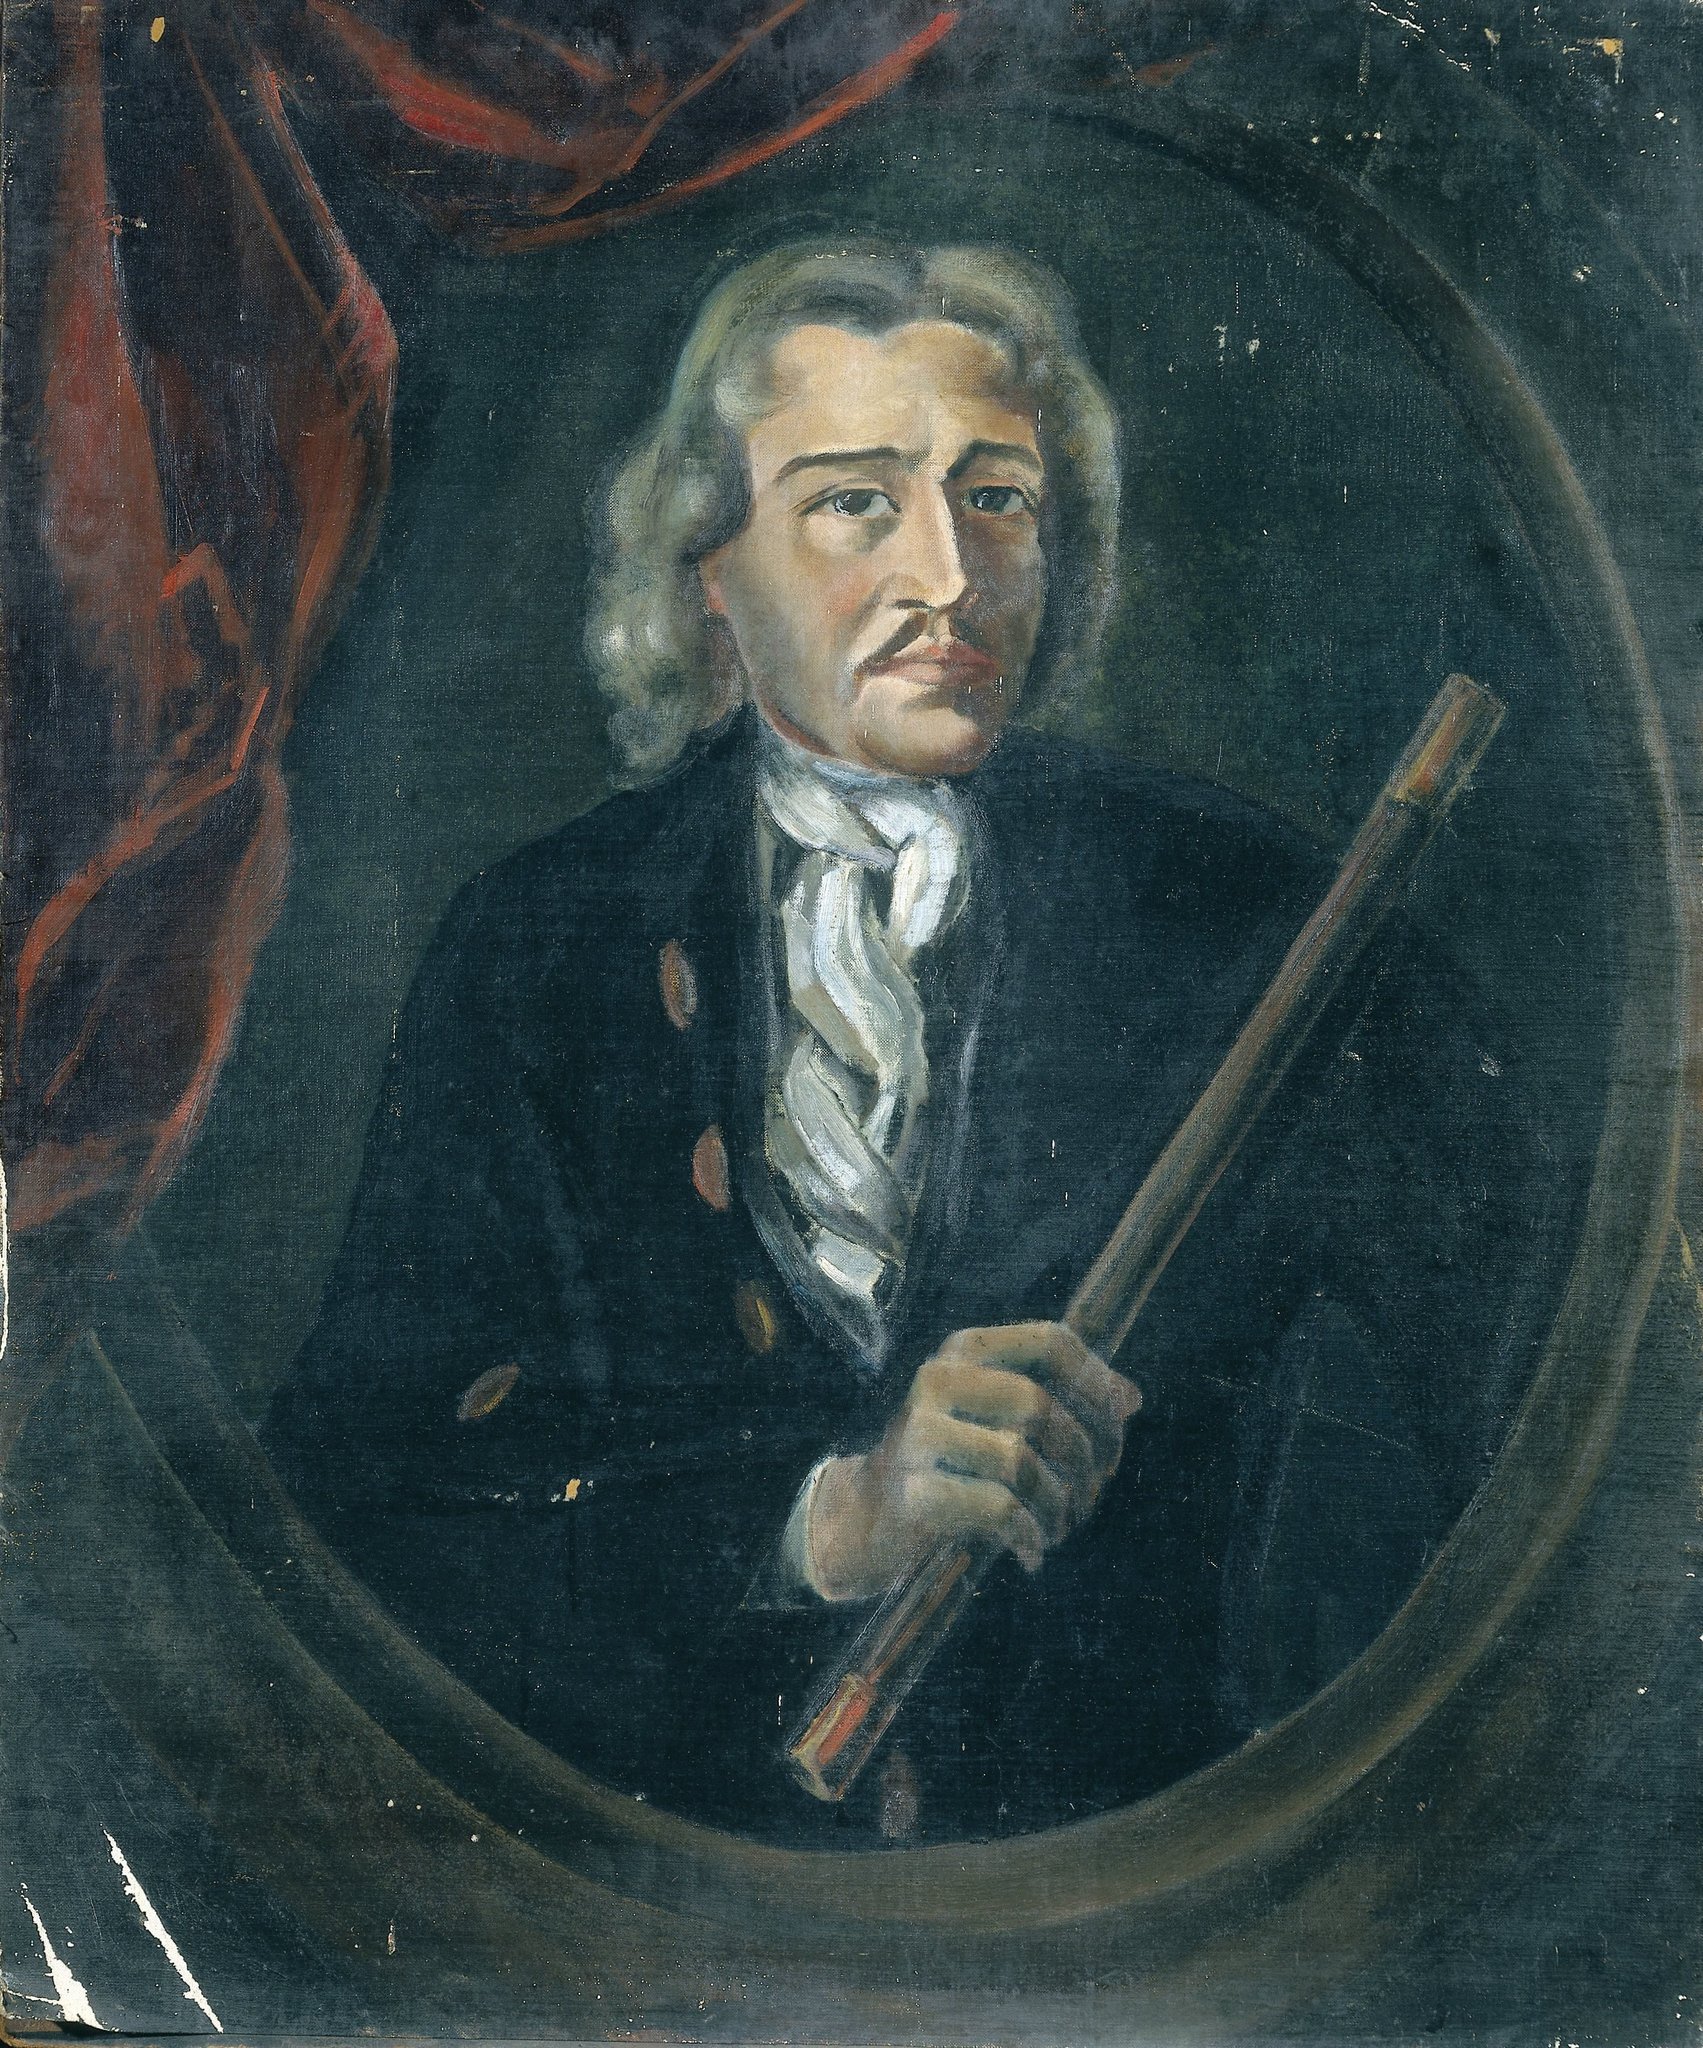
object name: painting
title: Joan van Hoorn (1653-1711). Gouverneur-generaal (1704-09)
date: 1800-1950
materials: canvas, cardboard, oil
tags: amsterdam, colonial governor, historical persons, dutch east indies, the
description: Portret van Joan van Hoorn (1653-1711). Gouverneur-generaal (1704-09). Ten halven lijve, in ovaal, commandostaf in de rechterhand. Moderne kopie naar het verloren gegaan origineel van Cornelis de Bruyn uit 1706. Onderdeel van een reeks van portretten van de gouverneurs-generaal van het voormalige Nederlands Oost-Indië.